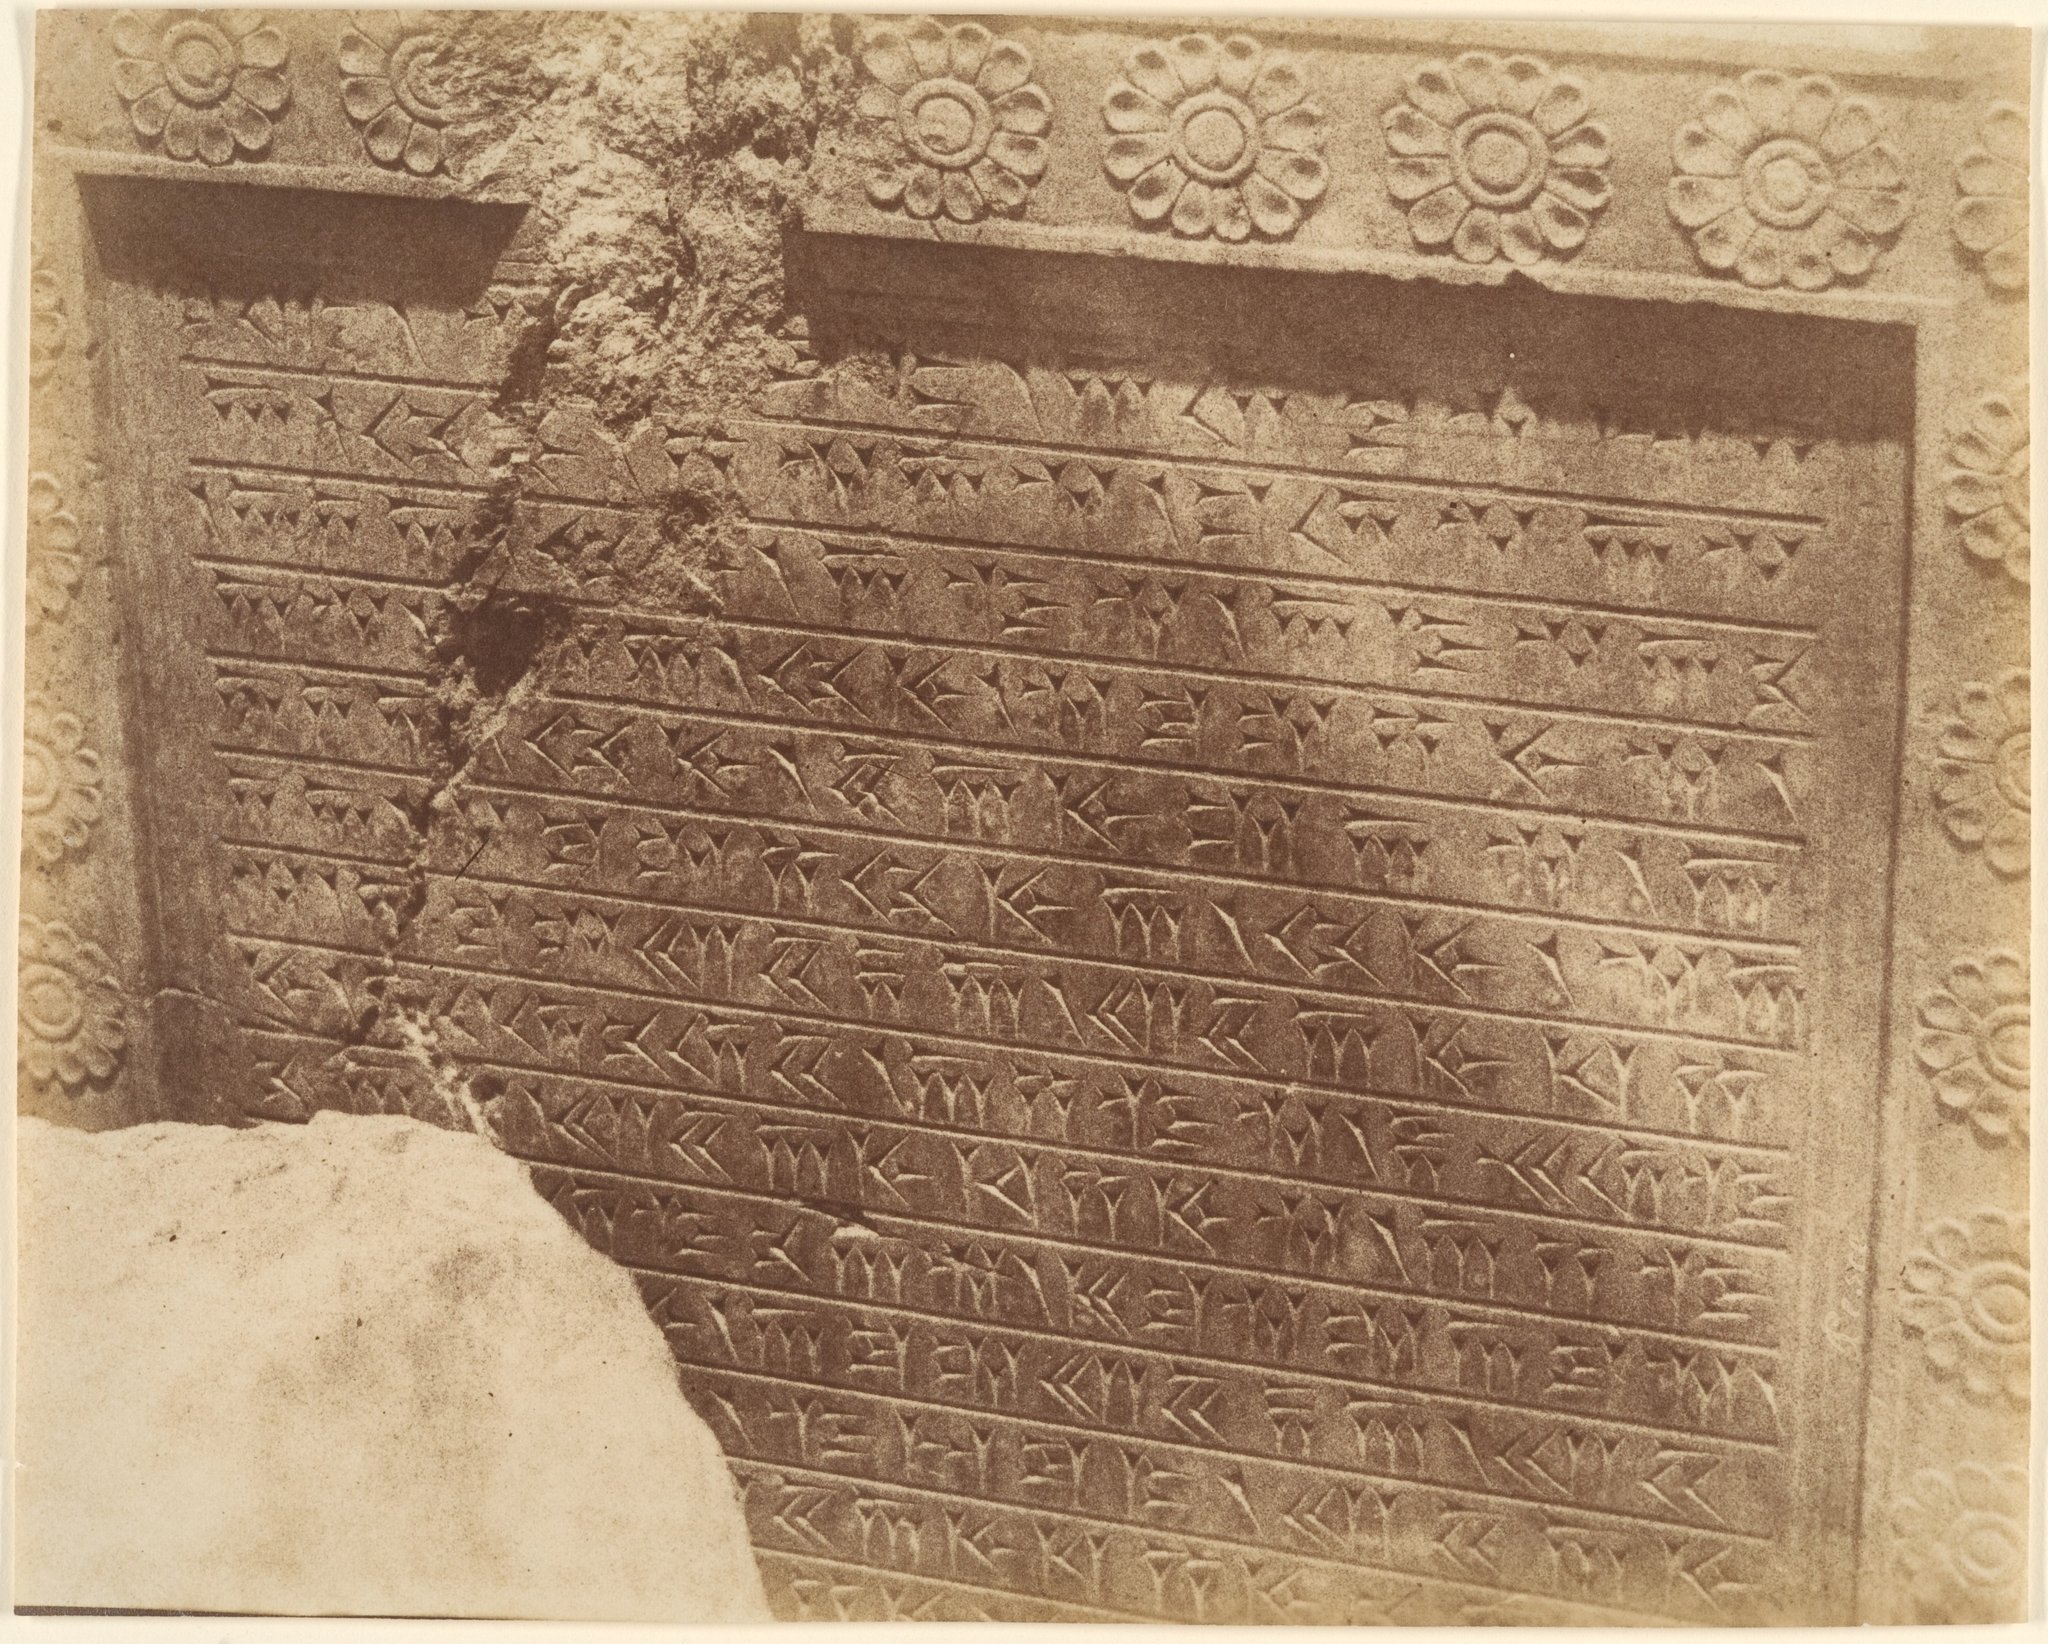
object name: photograph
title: (18) [Inscription, Old Persian in Cuneiform]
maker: luigi pesce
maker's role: artist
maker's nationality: italian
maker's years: 1818-1891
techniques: albumen silver print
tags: architecture